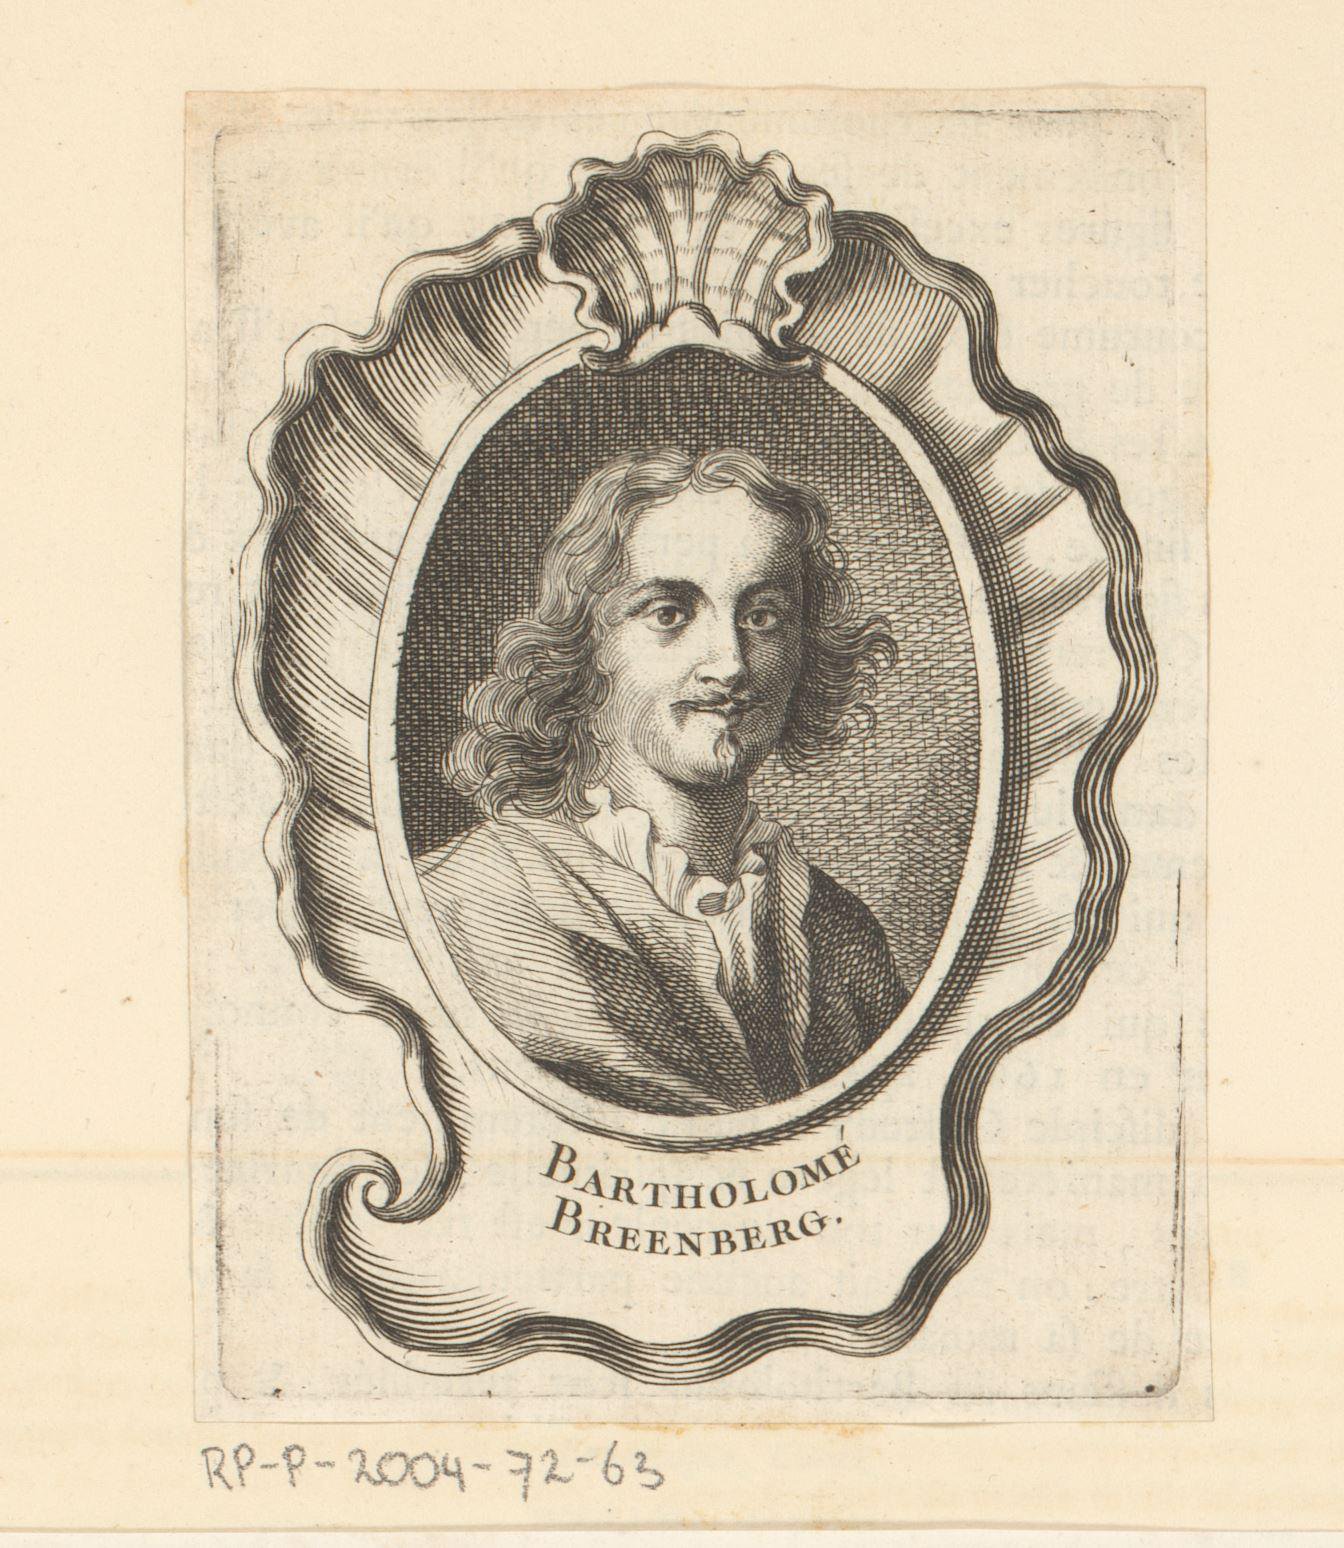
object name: book illustration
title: Bartholomé Breenberg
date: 1745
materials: paper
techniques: engraving, letterpress printing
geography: paris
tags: deventer, amsterdam, print maker, draughtsman, bartholomeus breenbergh, historical persons, portrait, self-portrait of painter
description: Prent uit: Dézallier d'Argenville, Antoine Joseph. Abrégé de la vie des plus fameux peintres. 4 dln. Parijs: De Bure l'aîné, 1745, dl. 2, p. 81. De samensteller heeft deze prent in het album geplakt als illustratie bij: Pilkington, Matthew en Johann Heinrich Füssli. A dictionary of painters, from the revival of the art to the present period. 4 dln. Londen: John Crowder, 1805, dl. 1, p. 81.